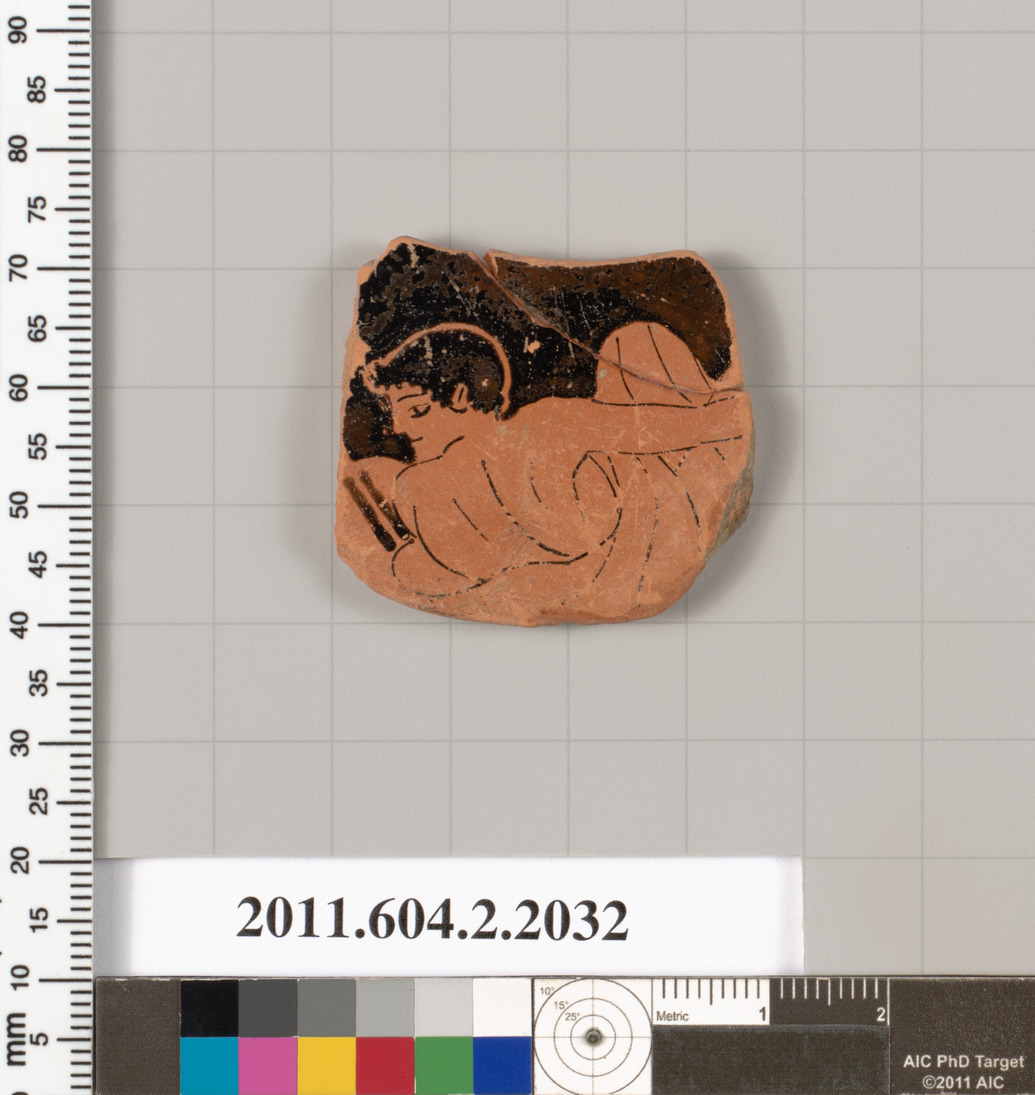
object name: strainer fragment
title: Terracotta fragment from a strainer?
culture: greek, attic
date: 475-451 BCE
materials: terracotta